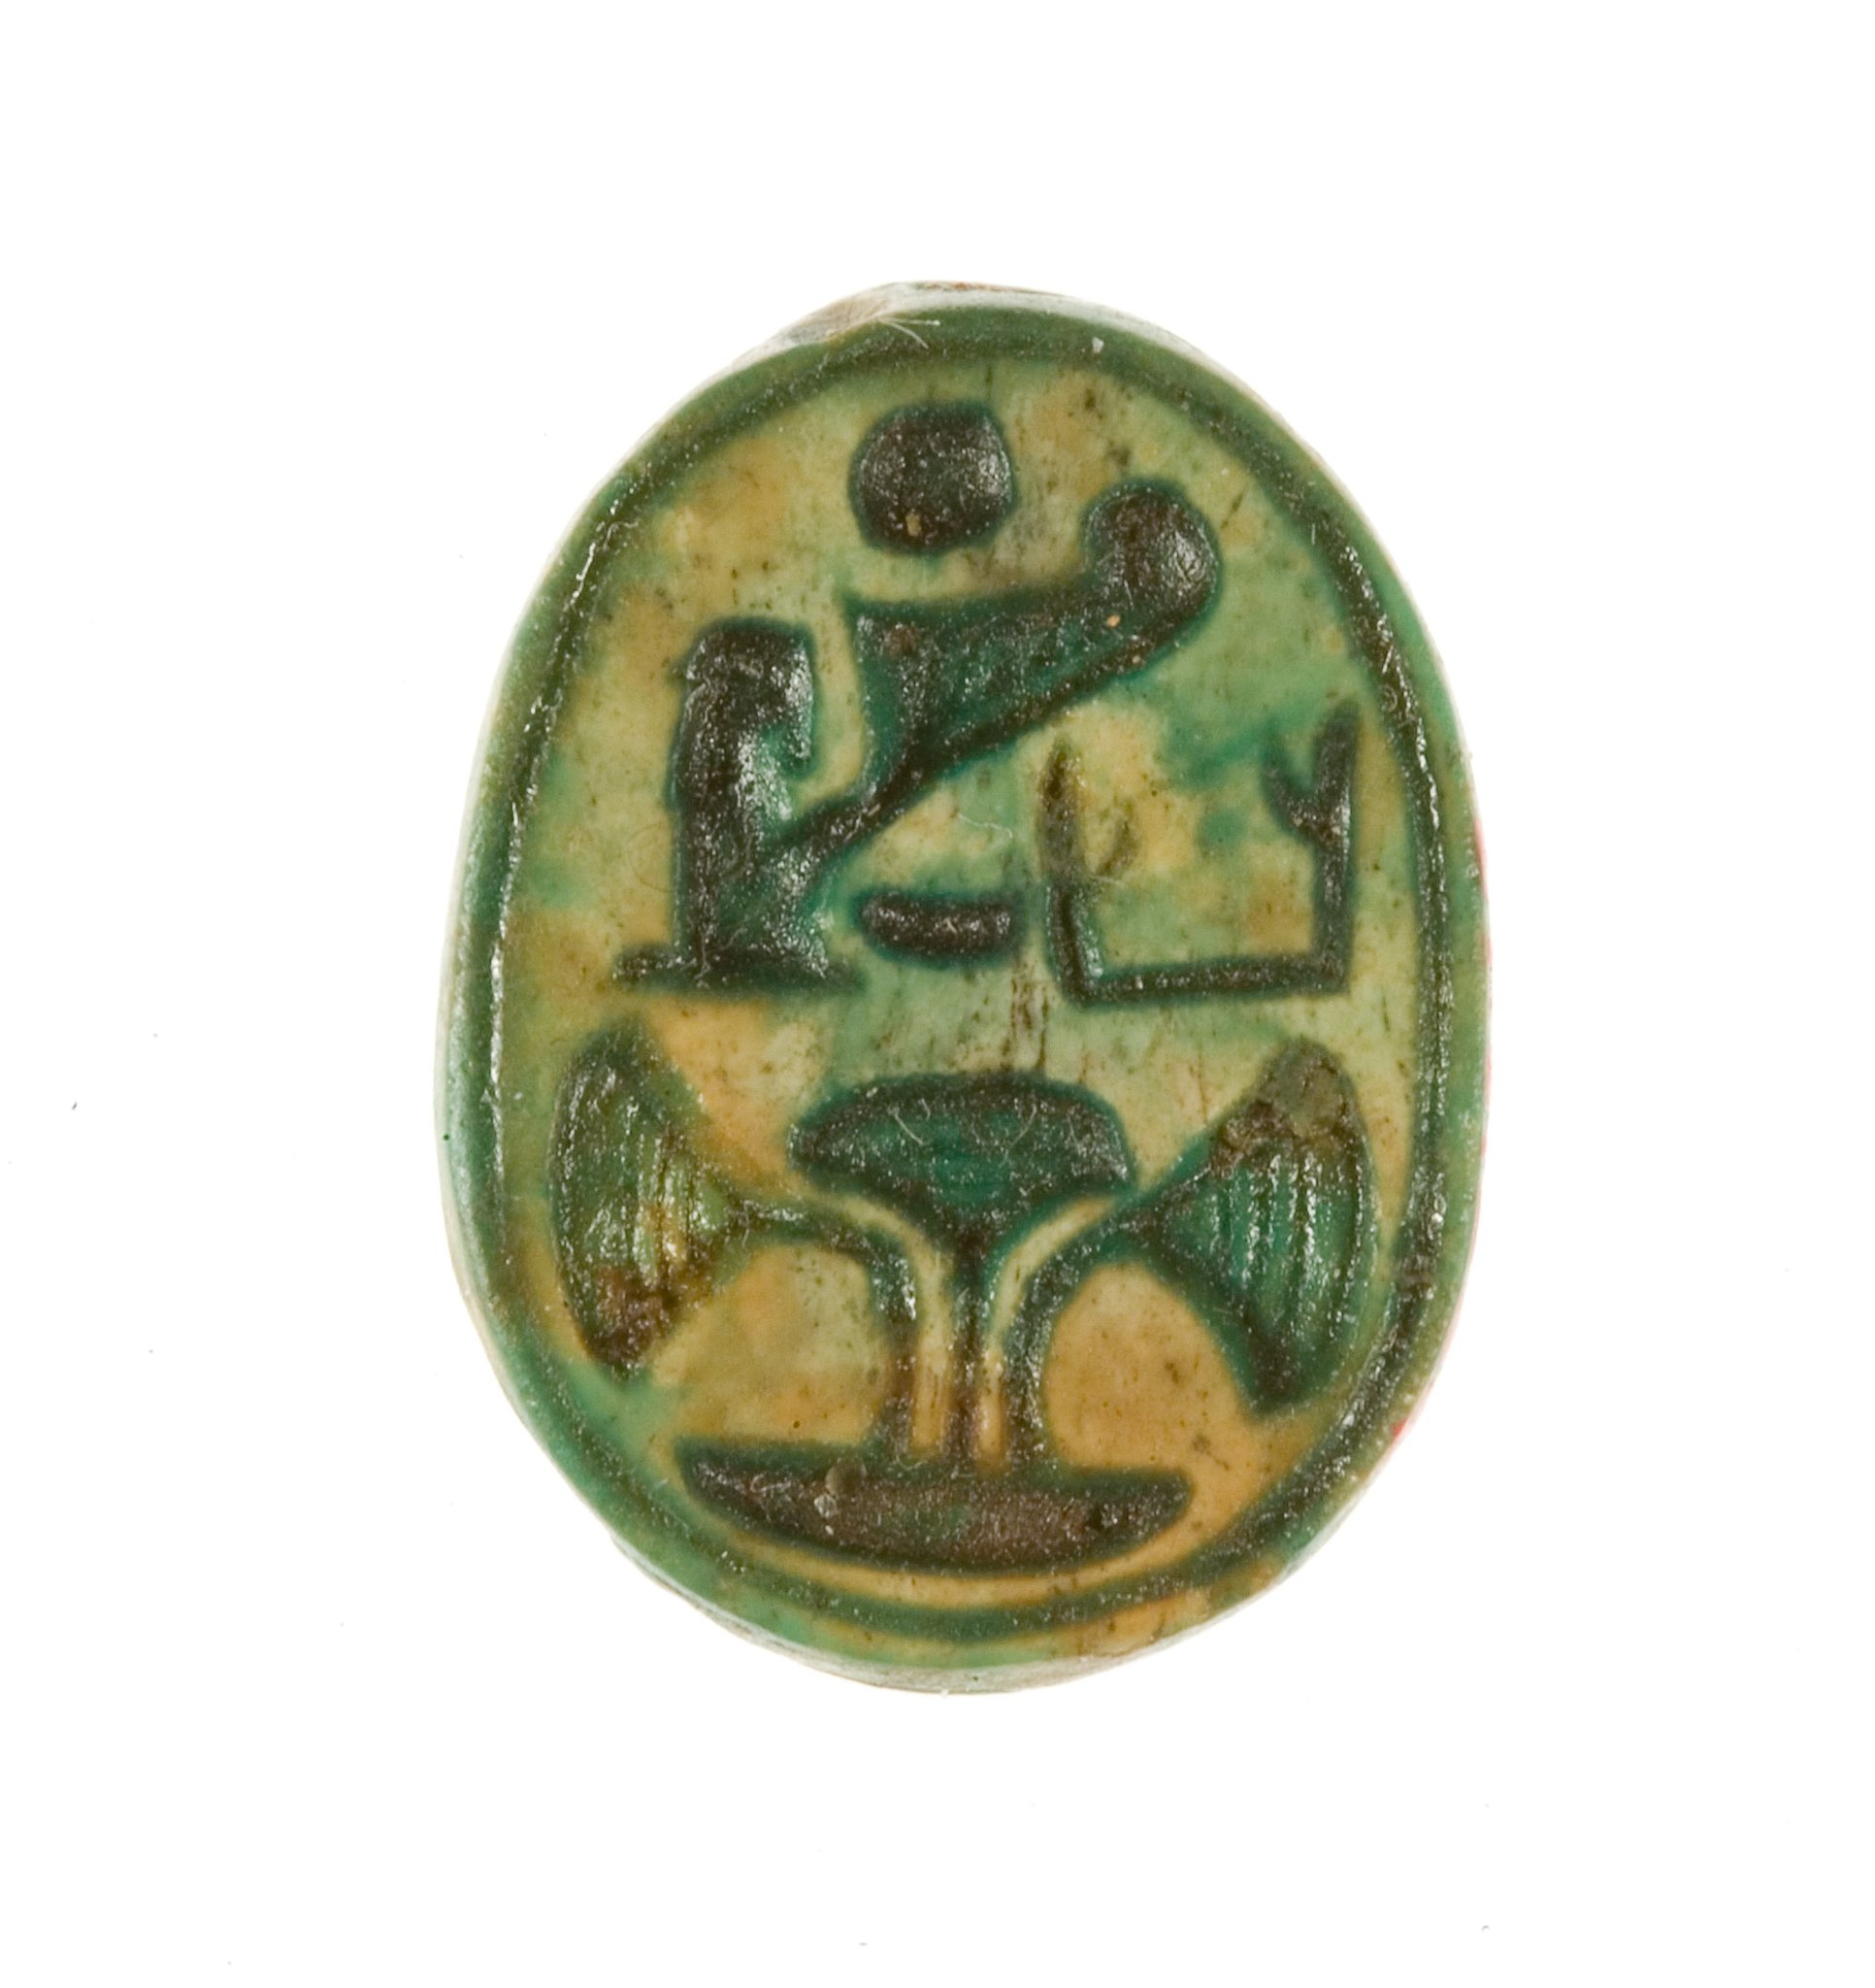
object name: scarab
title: Scarab Inscribed with the Name Maatkare Over a Papyrus Thicket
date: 1479-1458 BCE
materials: stone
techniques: glazing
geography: egypt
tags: hieroglyphs,scarabs